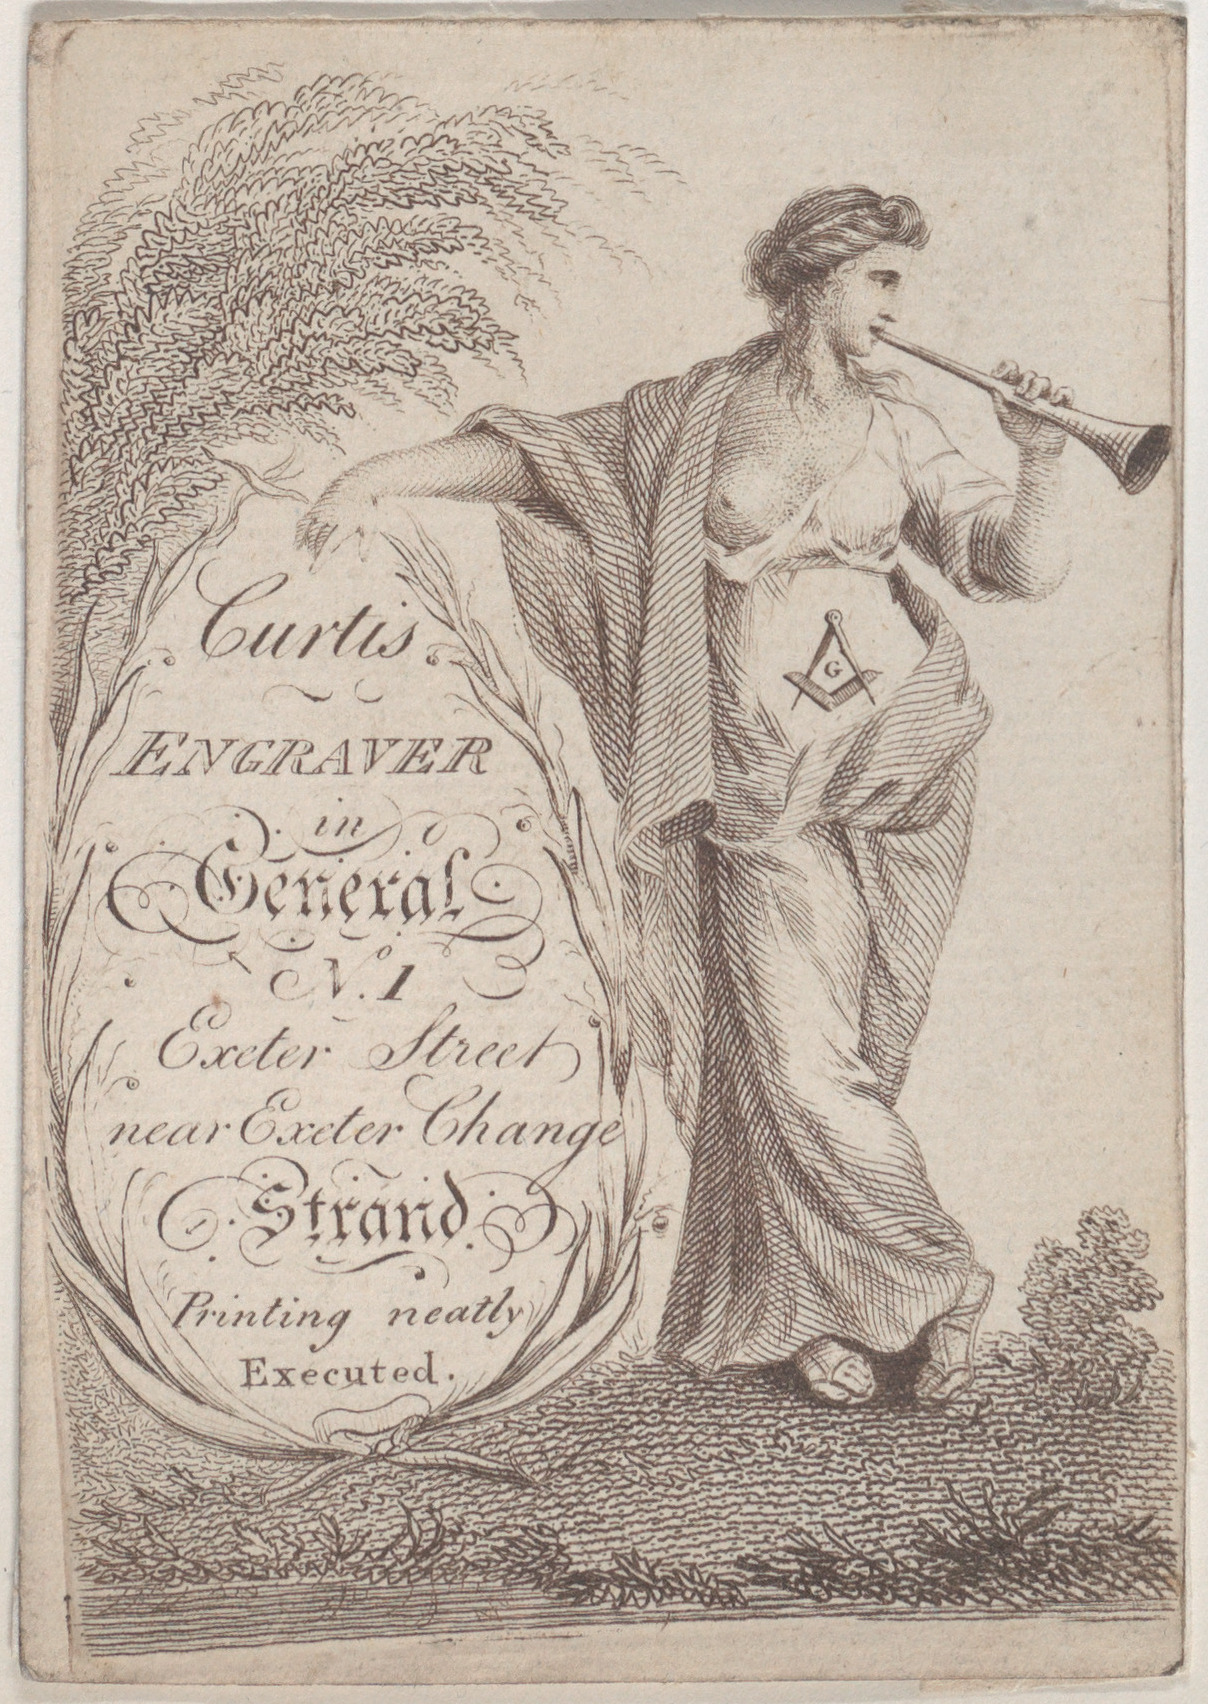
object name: print, trade card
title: Trade Card for Curtis, Engraver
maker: anonymous, british, 19th century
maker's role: artist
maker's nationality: british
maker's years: 1800-1900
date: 1801-1900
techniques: engraving